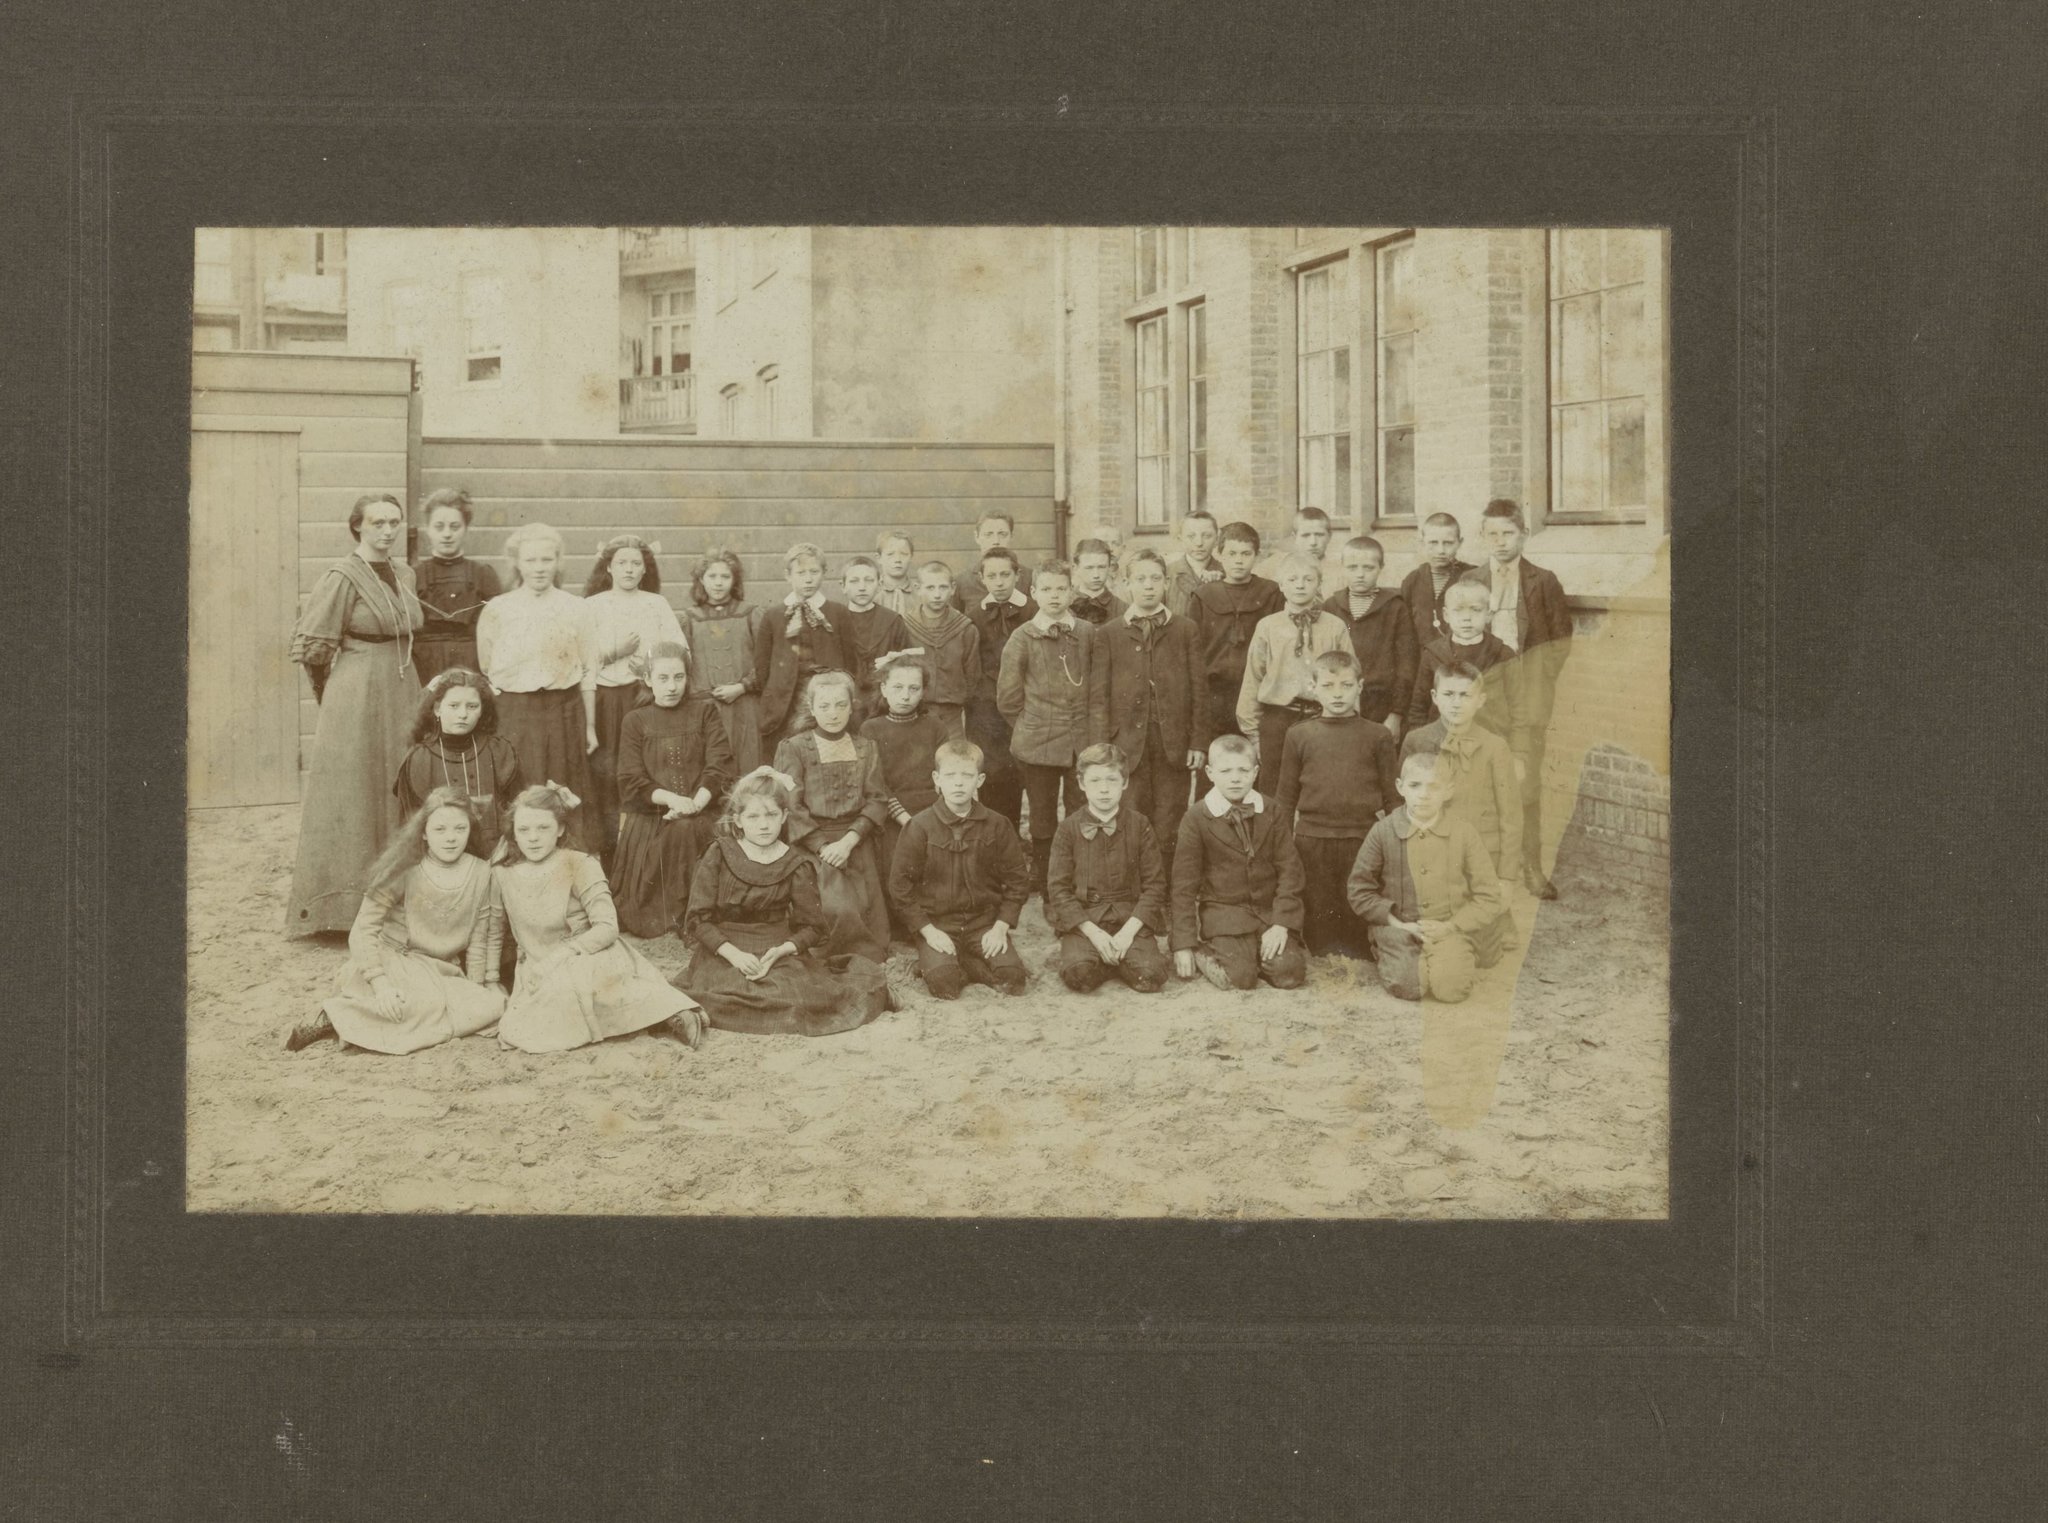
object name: photograph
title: Schoolfoto van een klas kinderen buiten bij school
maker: Anonymous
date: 1905-1915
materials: cardboard, photographic support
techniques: gelatin silver print